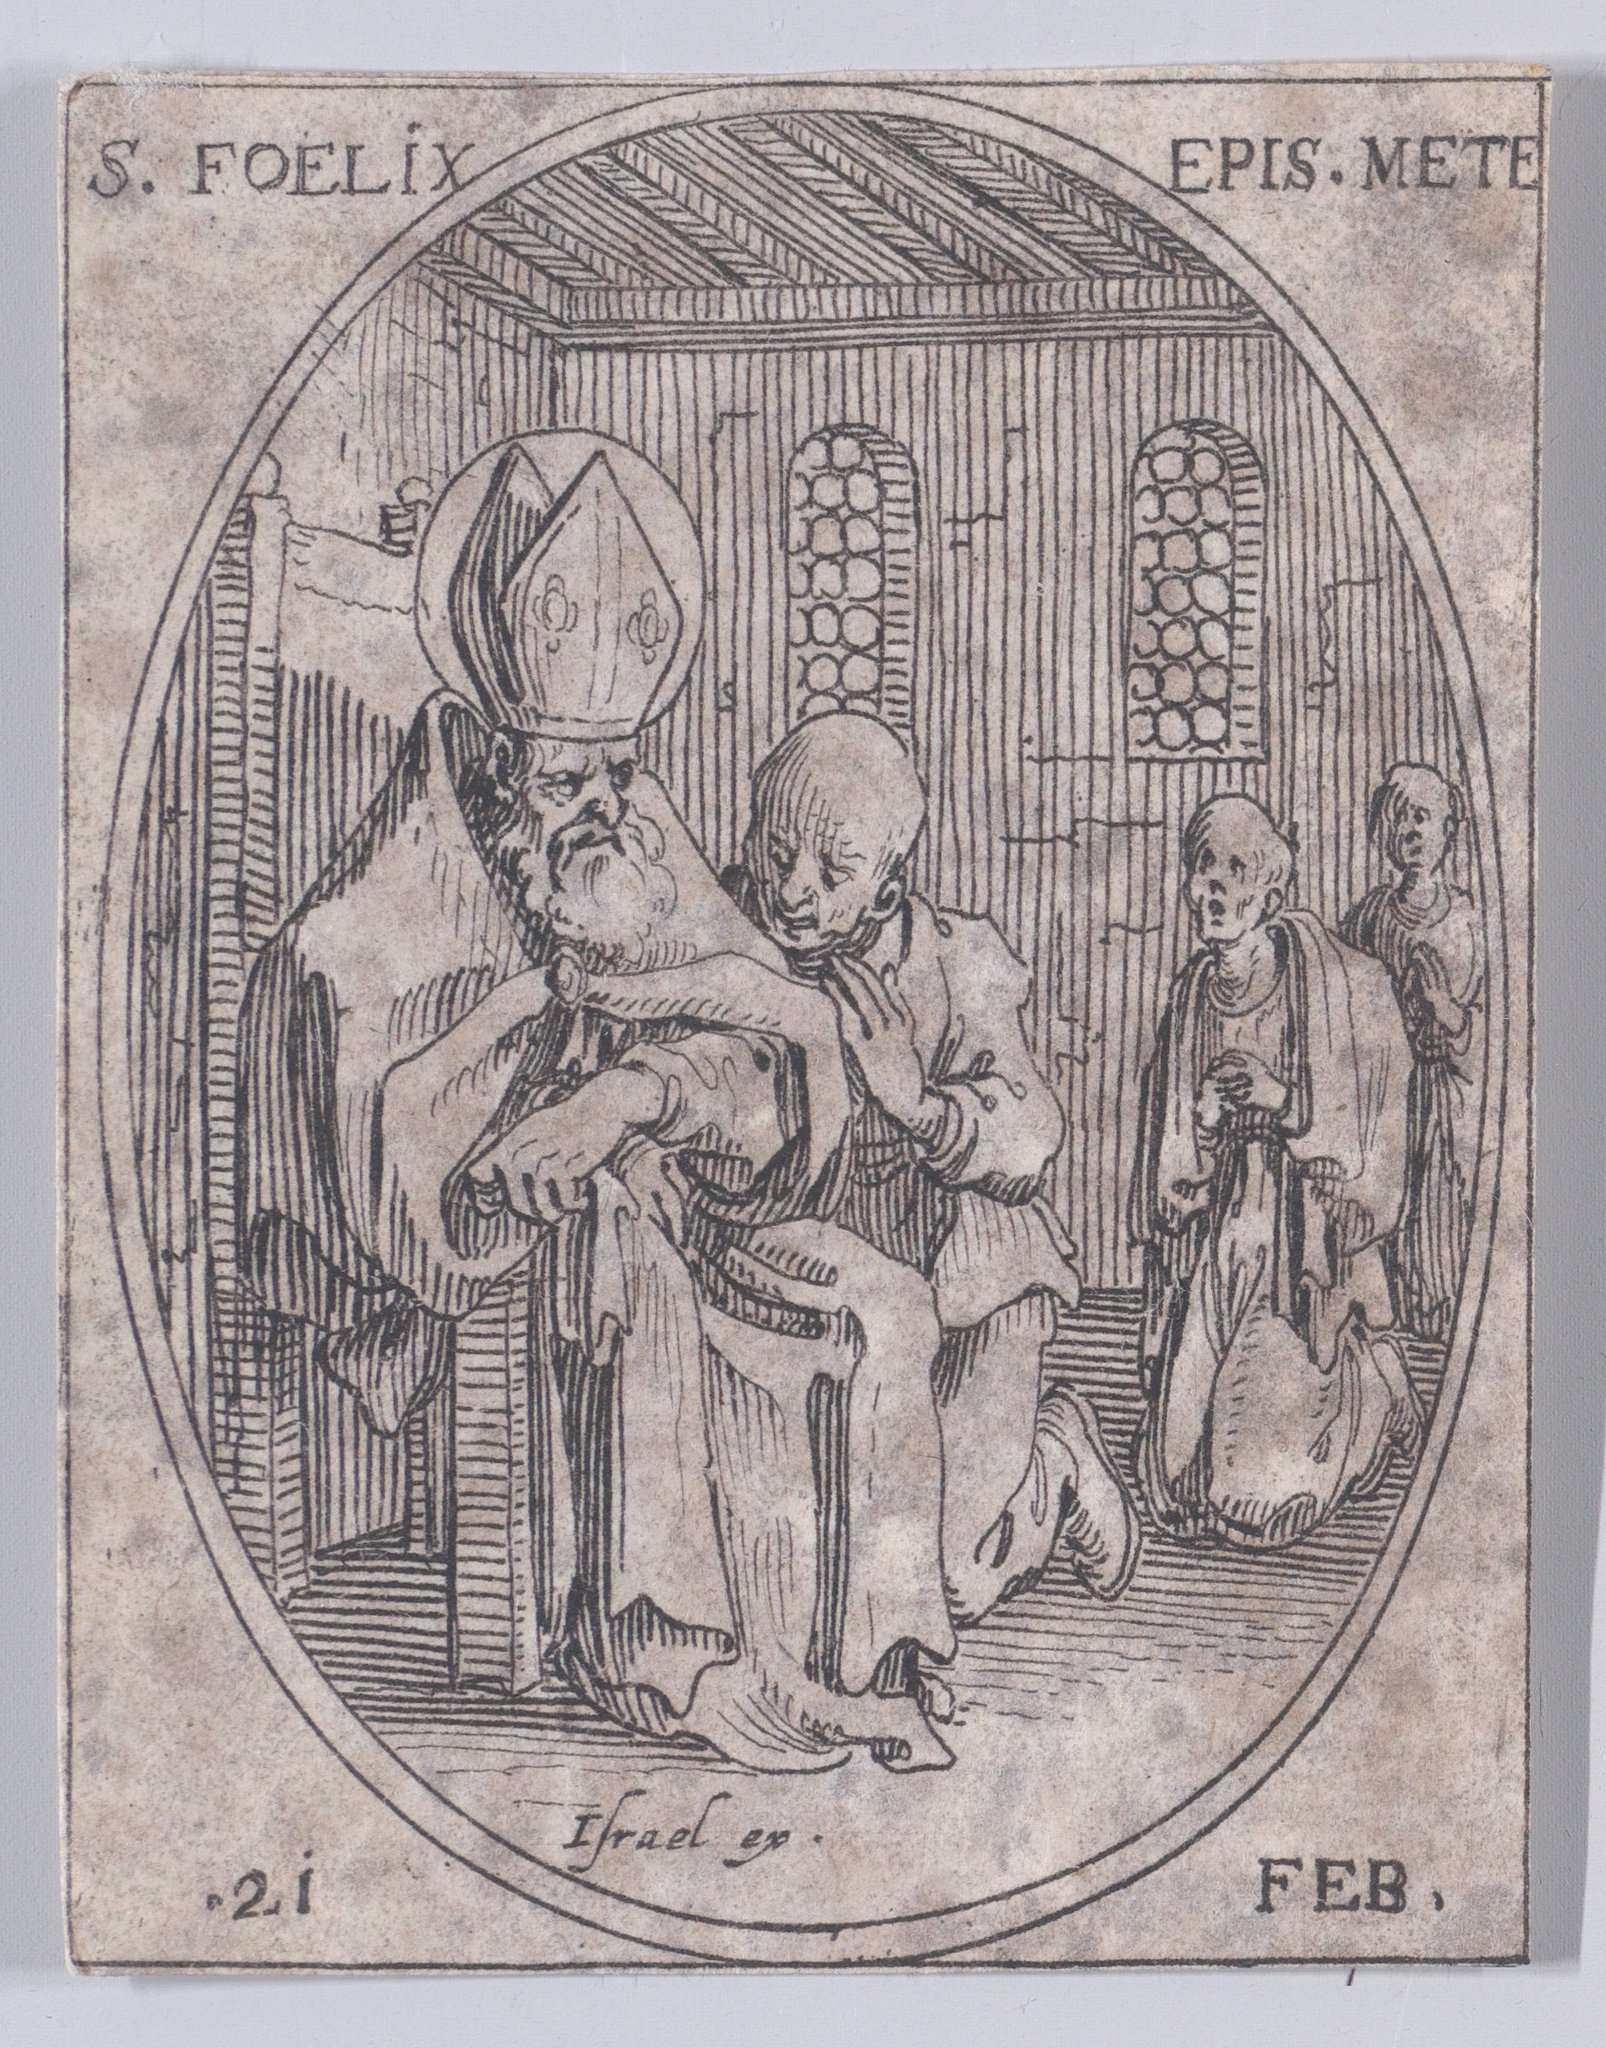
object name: print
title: S. Polycarpe (St. Polycarp), February 23rd, from "Les Images De Tous Les Saincts et Saintes de L'Année" (Images of All of the Saints and Religious Events of the Year)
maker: jacques callot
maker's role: artist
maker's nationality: french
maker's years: 1592-1635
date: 1636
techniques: etching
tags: men,saints